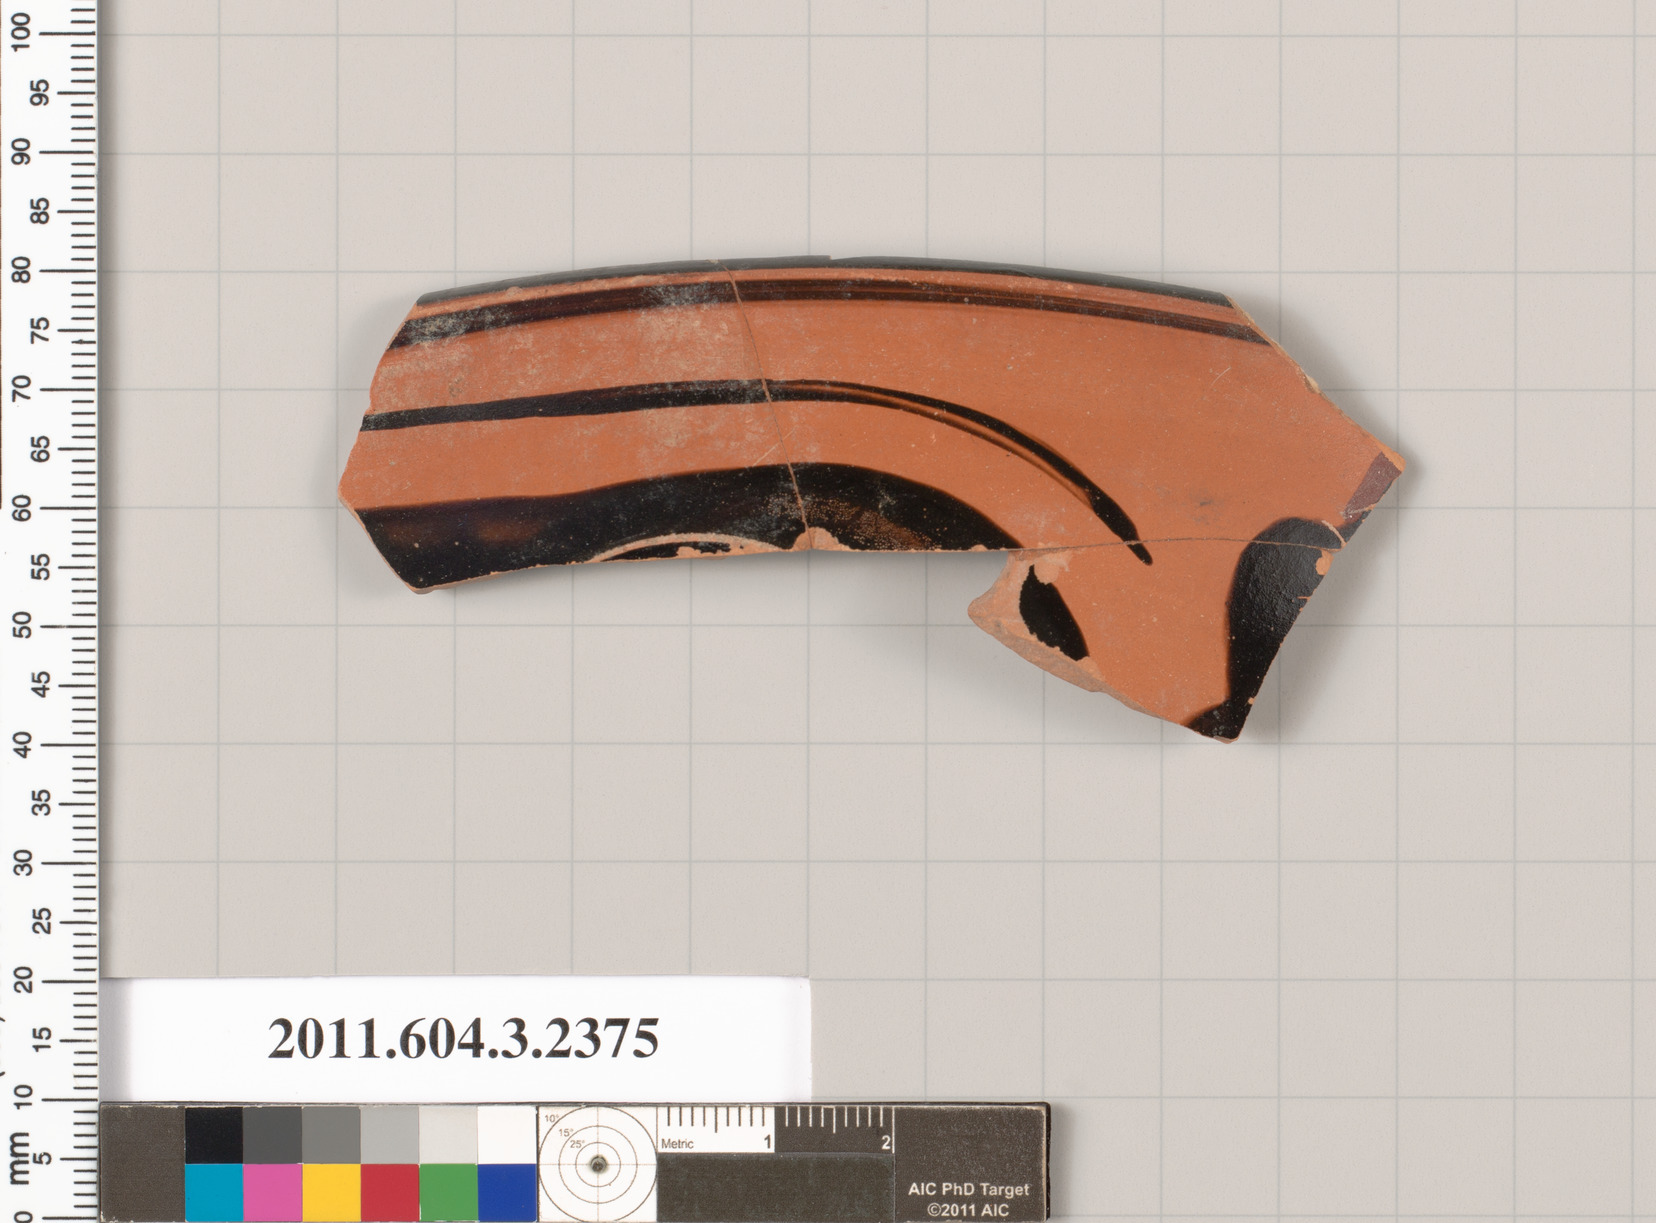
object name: kylix fragment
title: Terracotta rim fragment of a kylix: eye-cup (drinking cup)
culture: greek, attic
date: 525-501 BCE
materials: terracotta